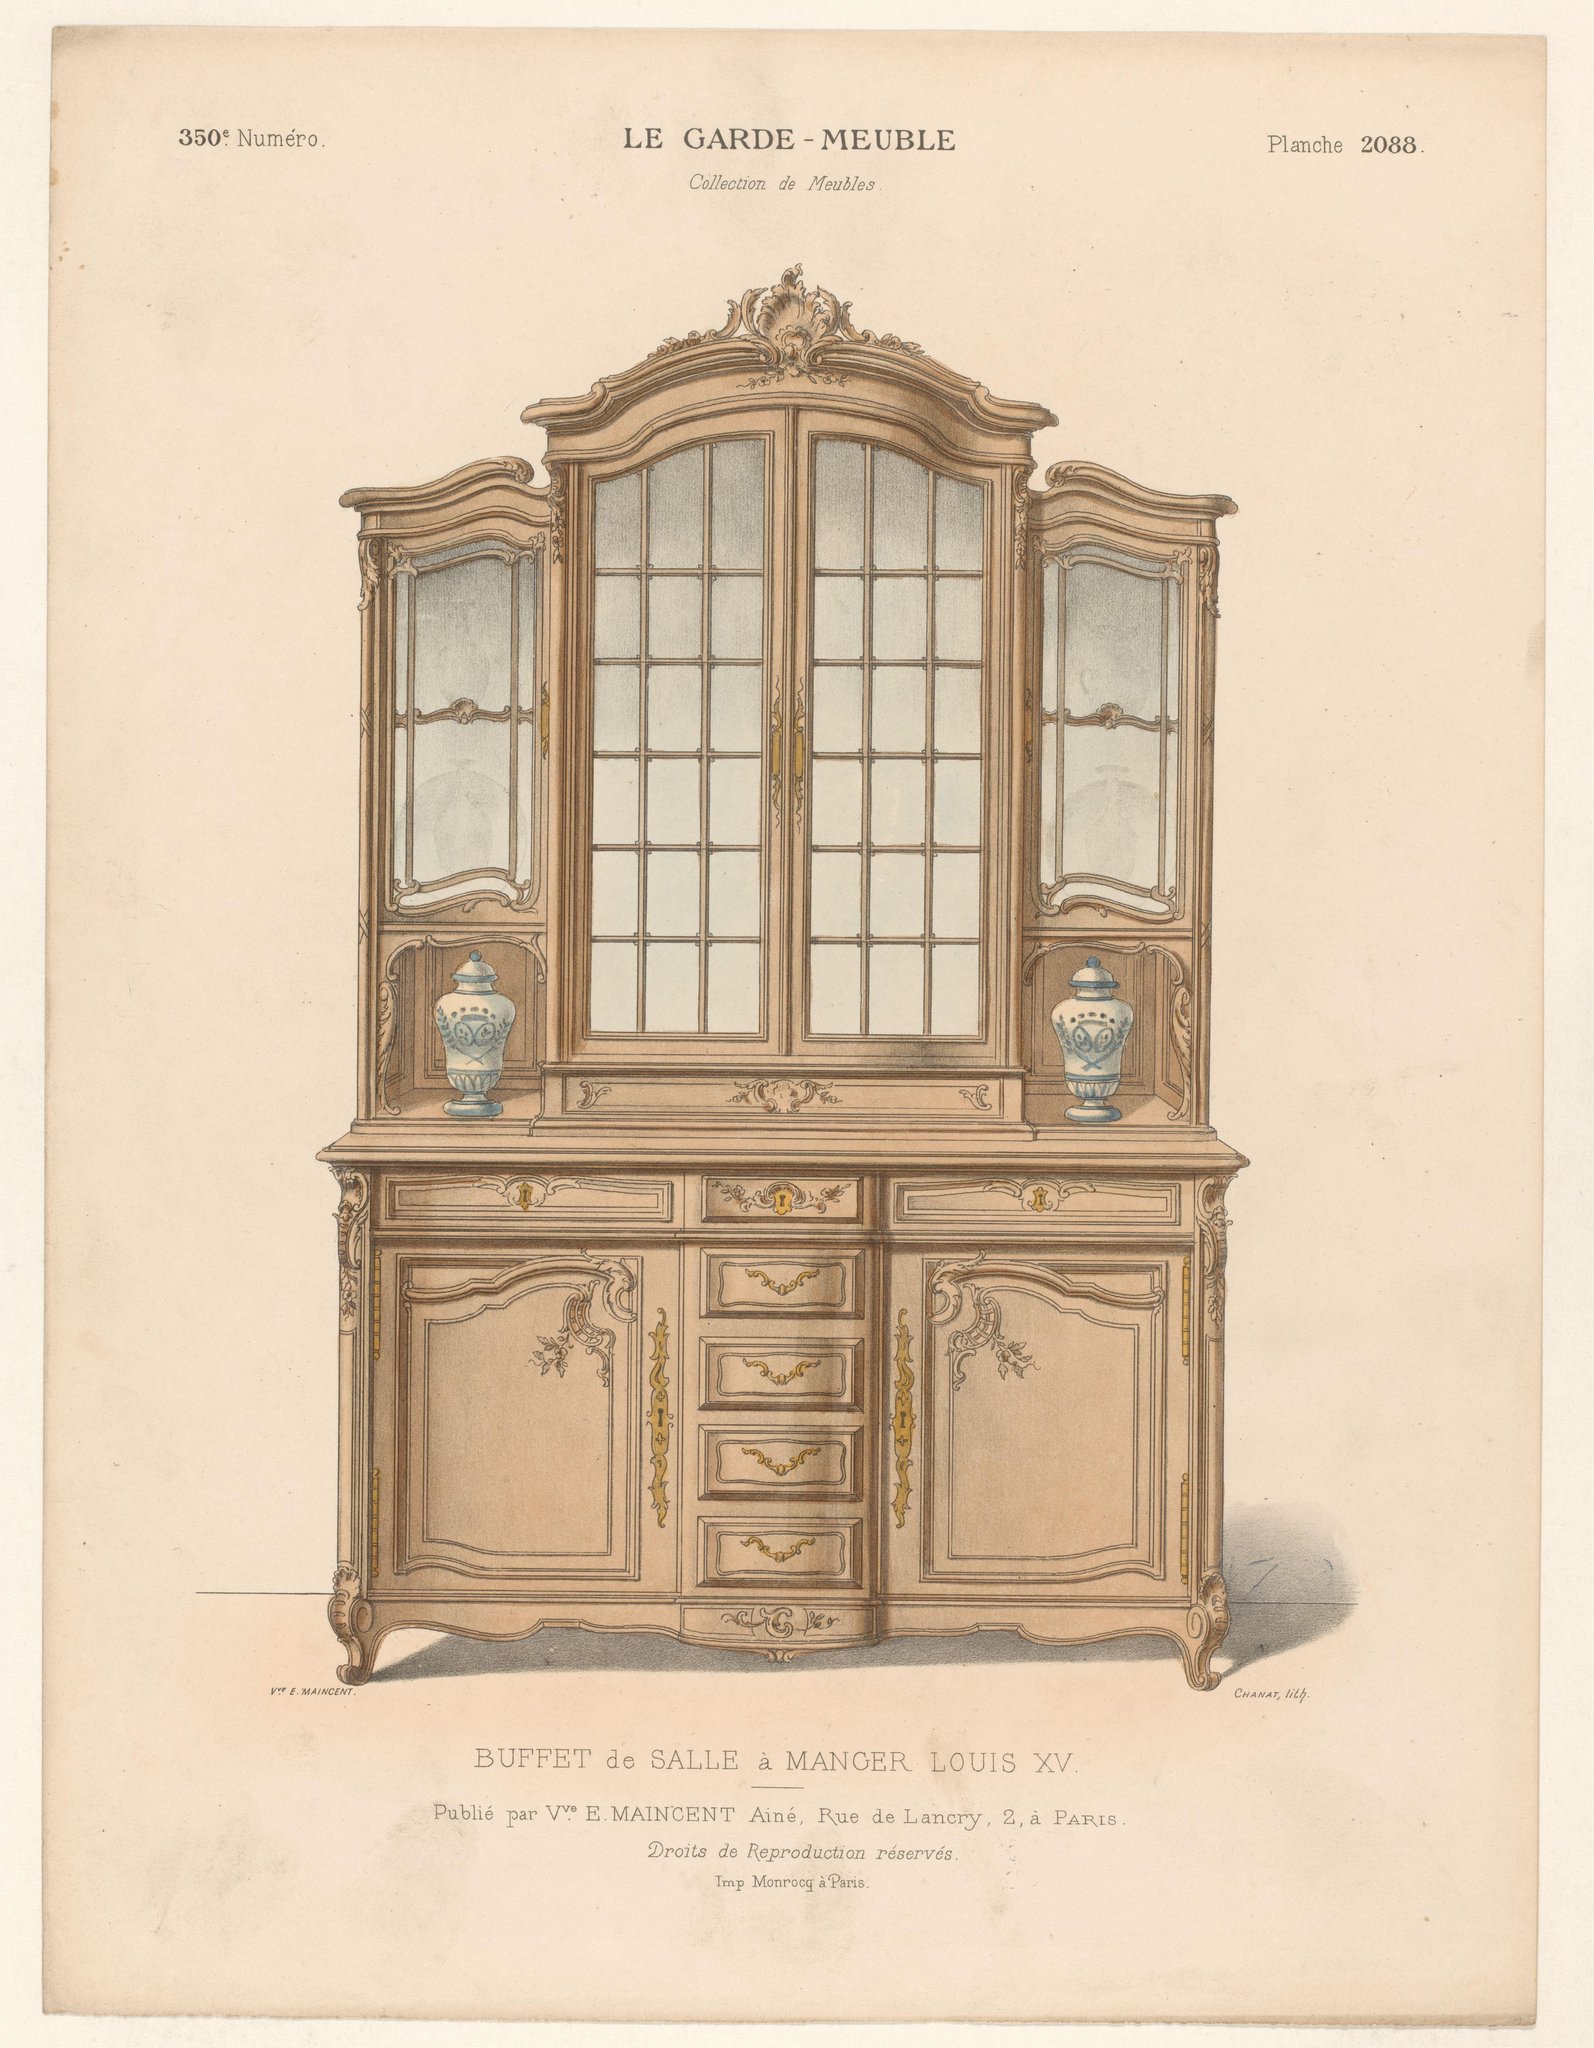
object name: print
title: Buffet de salle à manger Louis XV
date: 1895-1935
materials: paper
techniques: hand coloring, lithograph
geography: paris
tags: furniture for storage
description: Ieder Livraison in de serie Le Garde-Meuble bevat negen platen: drie 'sièges' (zitmeubels), drie 'meubles' (diverse meubels zoals tafels en kasten) en drie 'tentures' (gordijnen en draperieën).